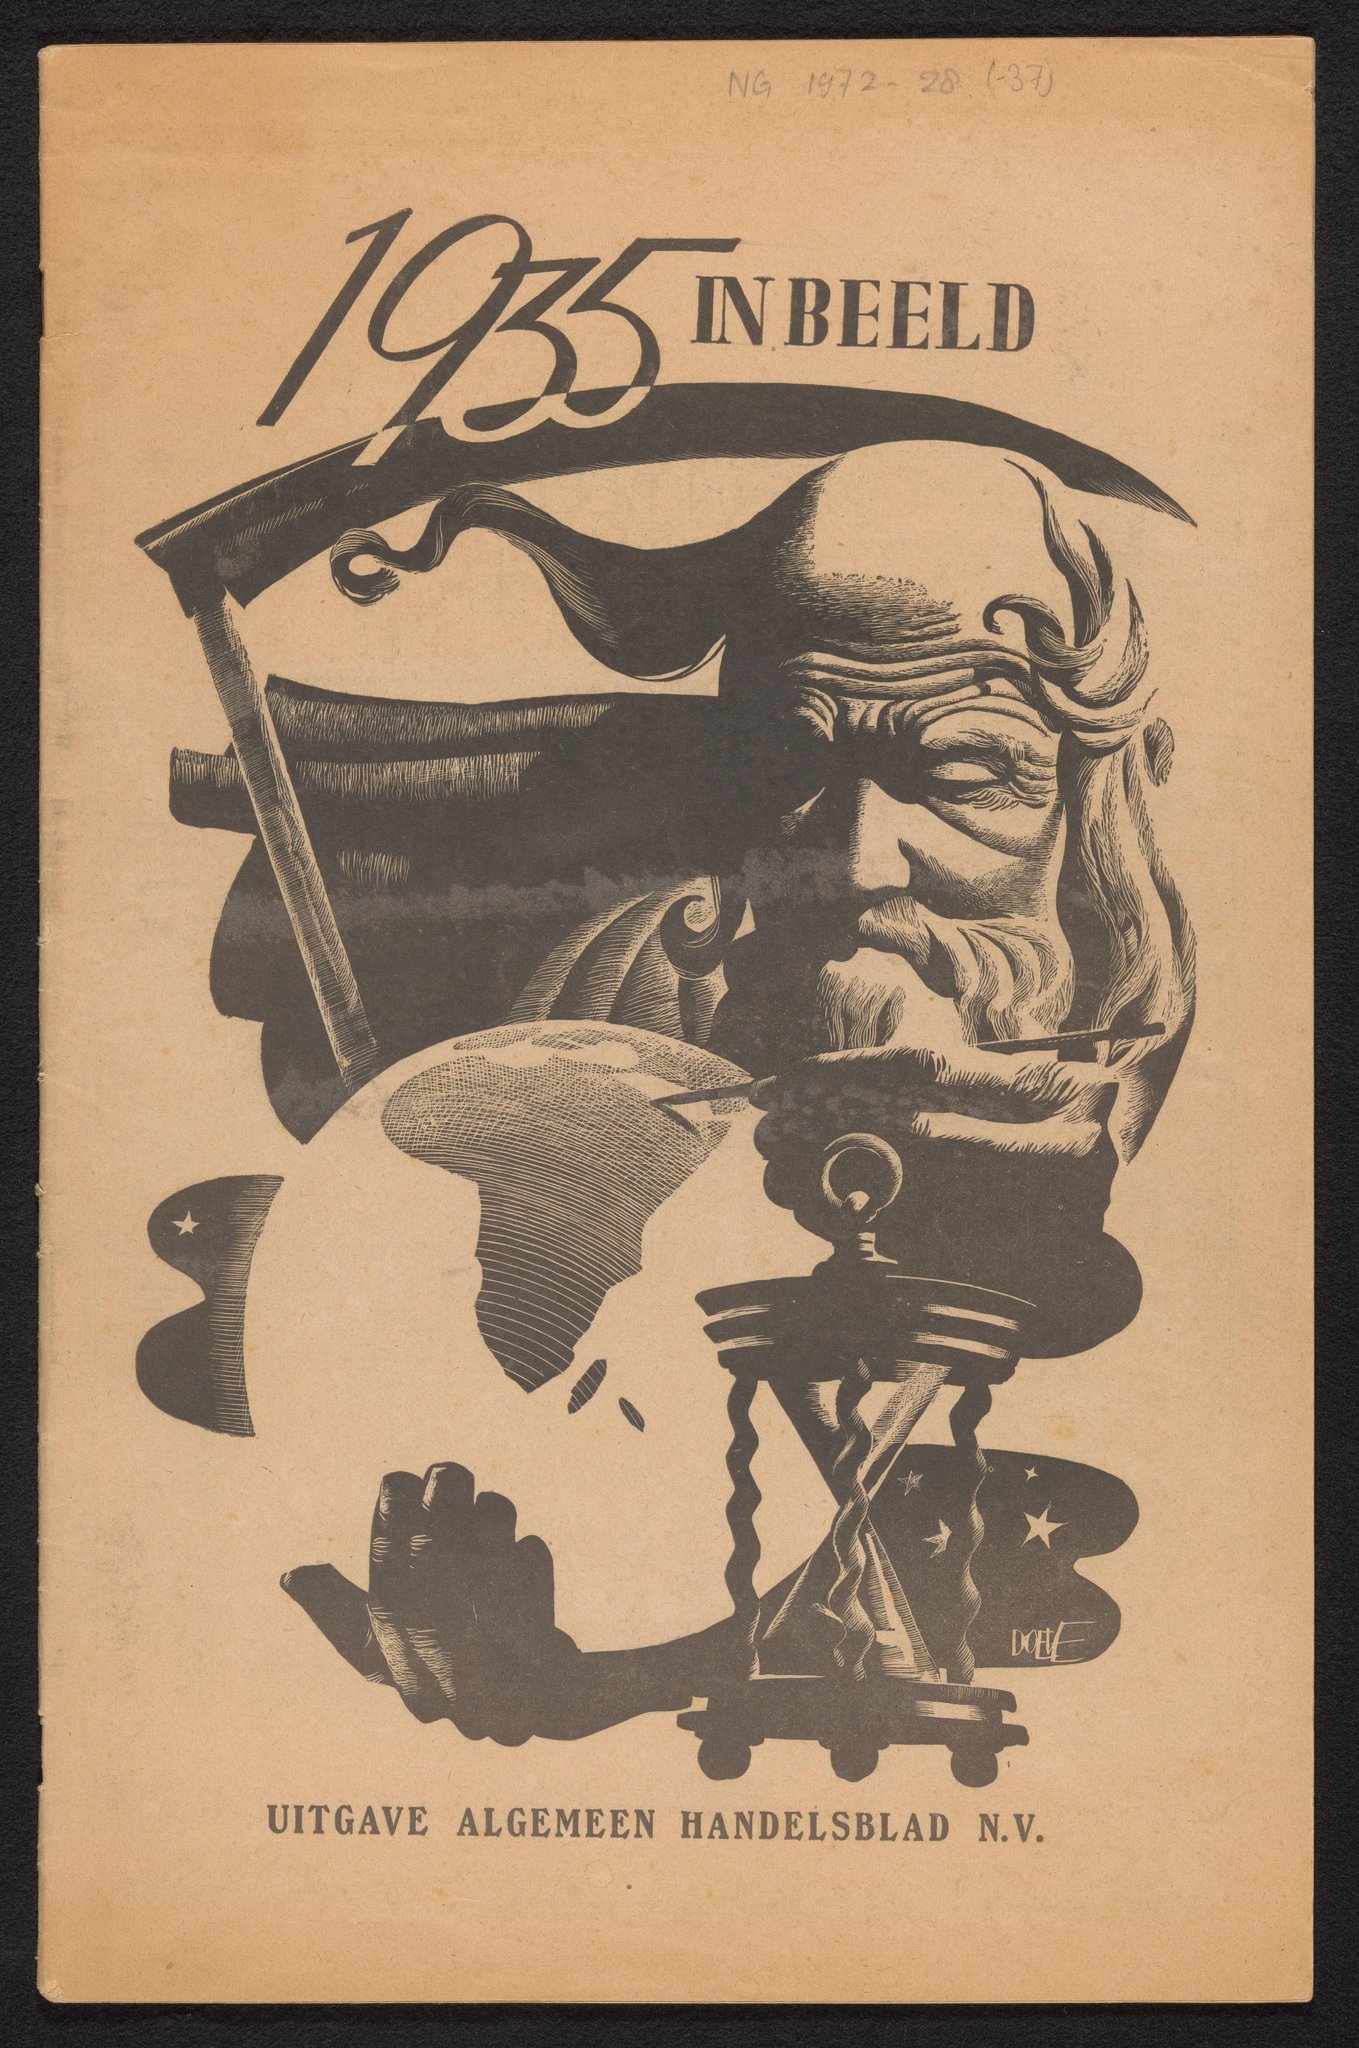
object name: supplement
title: 1935 in beeld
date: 1936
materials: paper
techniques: printing, stapling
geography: amsterdam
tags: netherlands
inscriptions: date